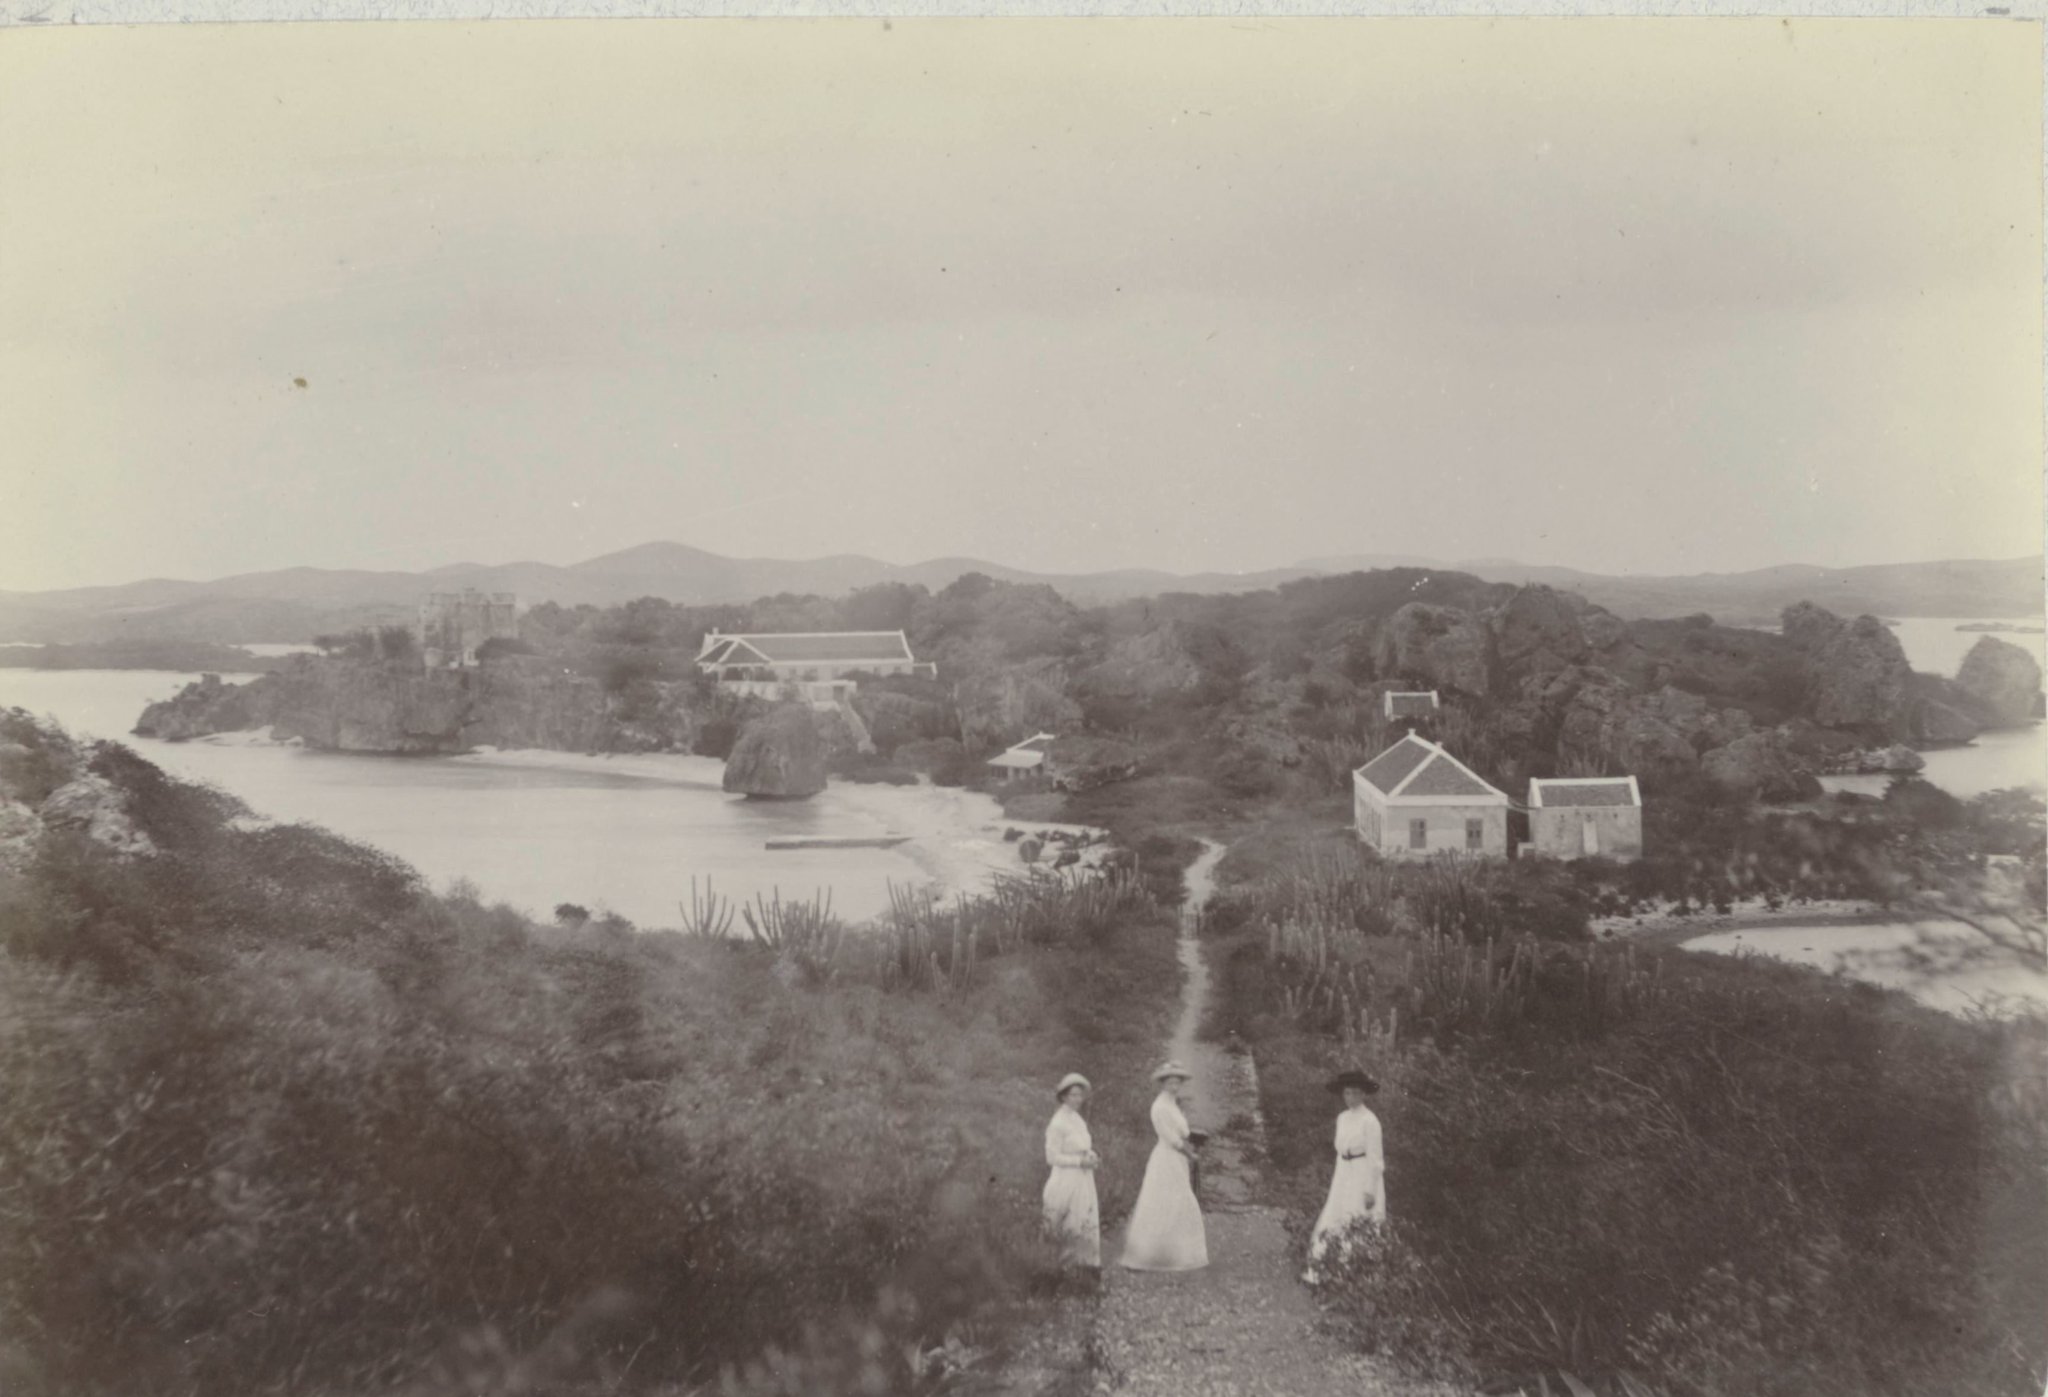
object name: photograph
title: Caracas Baai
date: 1906-1910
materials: photographic support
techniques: photography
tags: caracasbaai, curaçao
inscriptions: inscription: ‘Caracas Baai met Quarantaine etablissement Curaçao Juni 1910 / Mej. Stene. Mej. Kruyt. Mevr. Wessel’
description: Caracas Baai met het Quarantainegebouw, Curaçao, juni 1910. Op het pad drie vrouwen. Onderdeel van het fotoalbum van de familie Boom-Gonggrijp in Suriname en Curaçao.